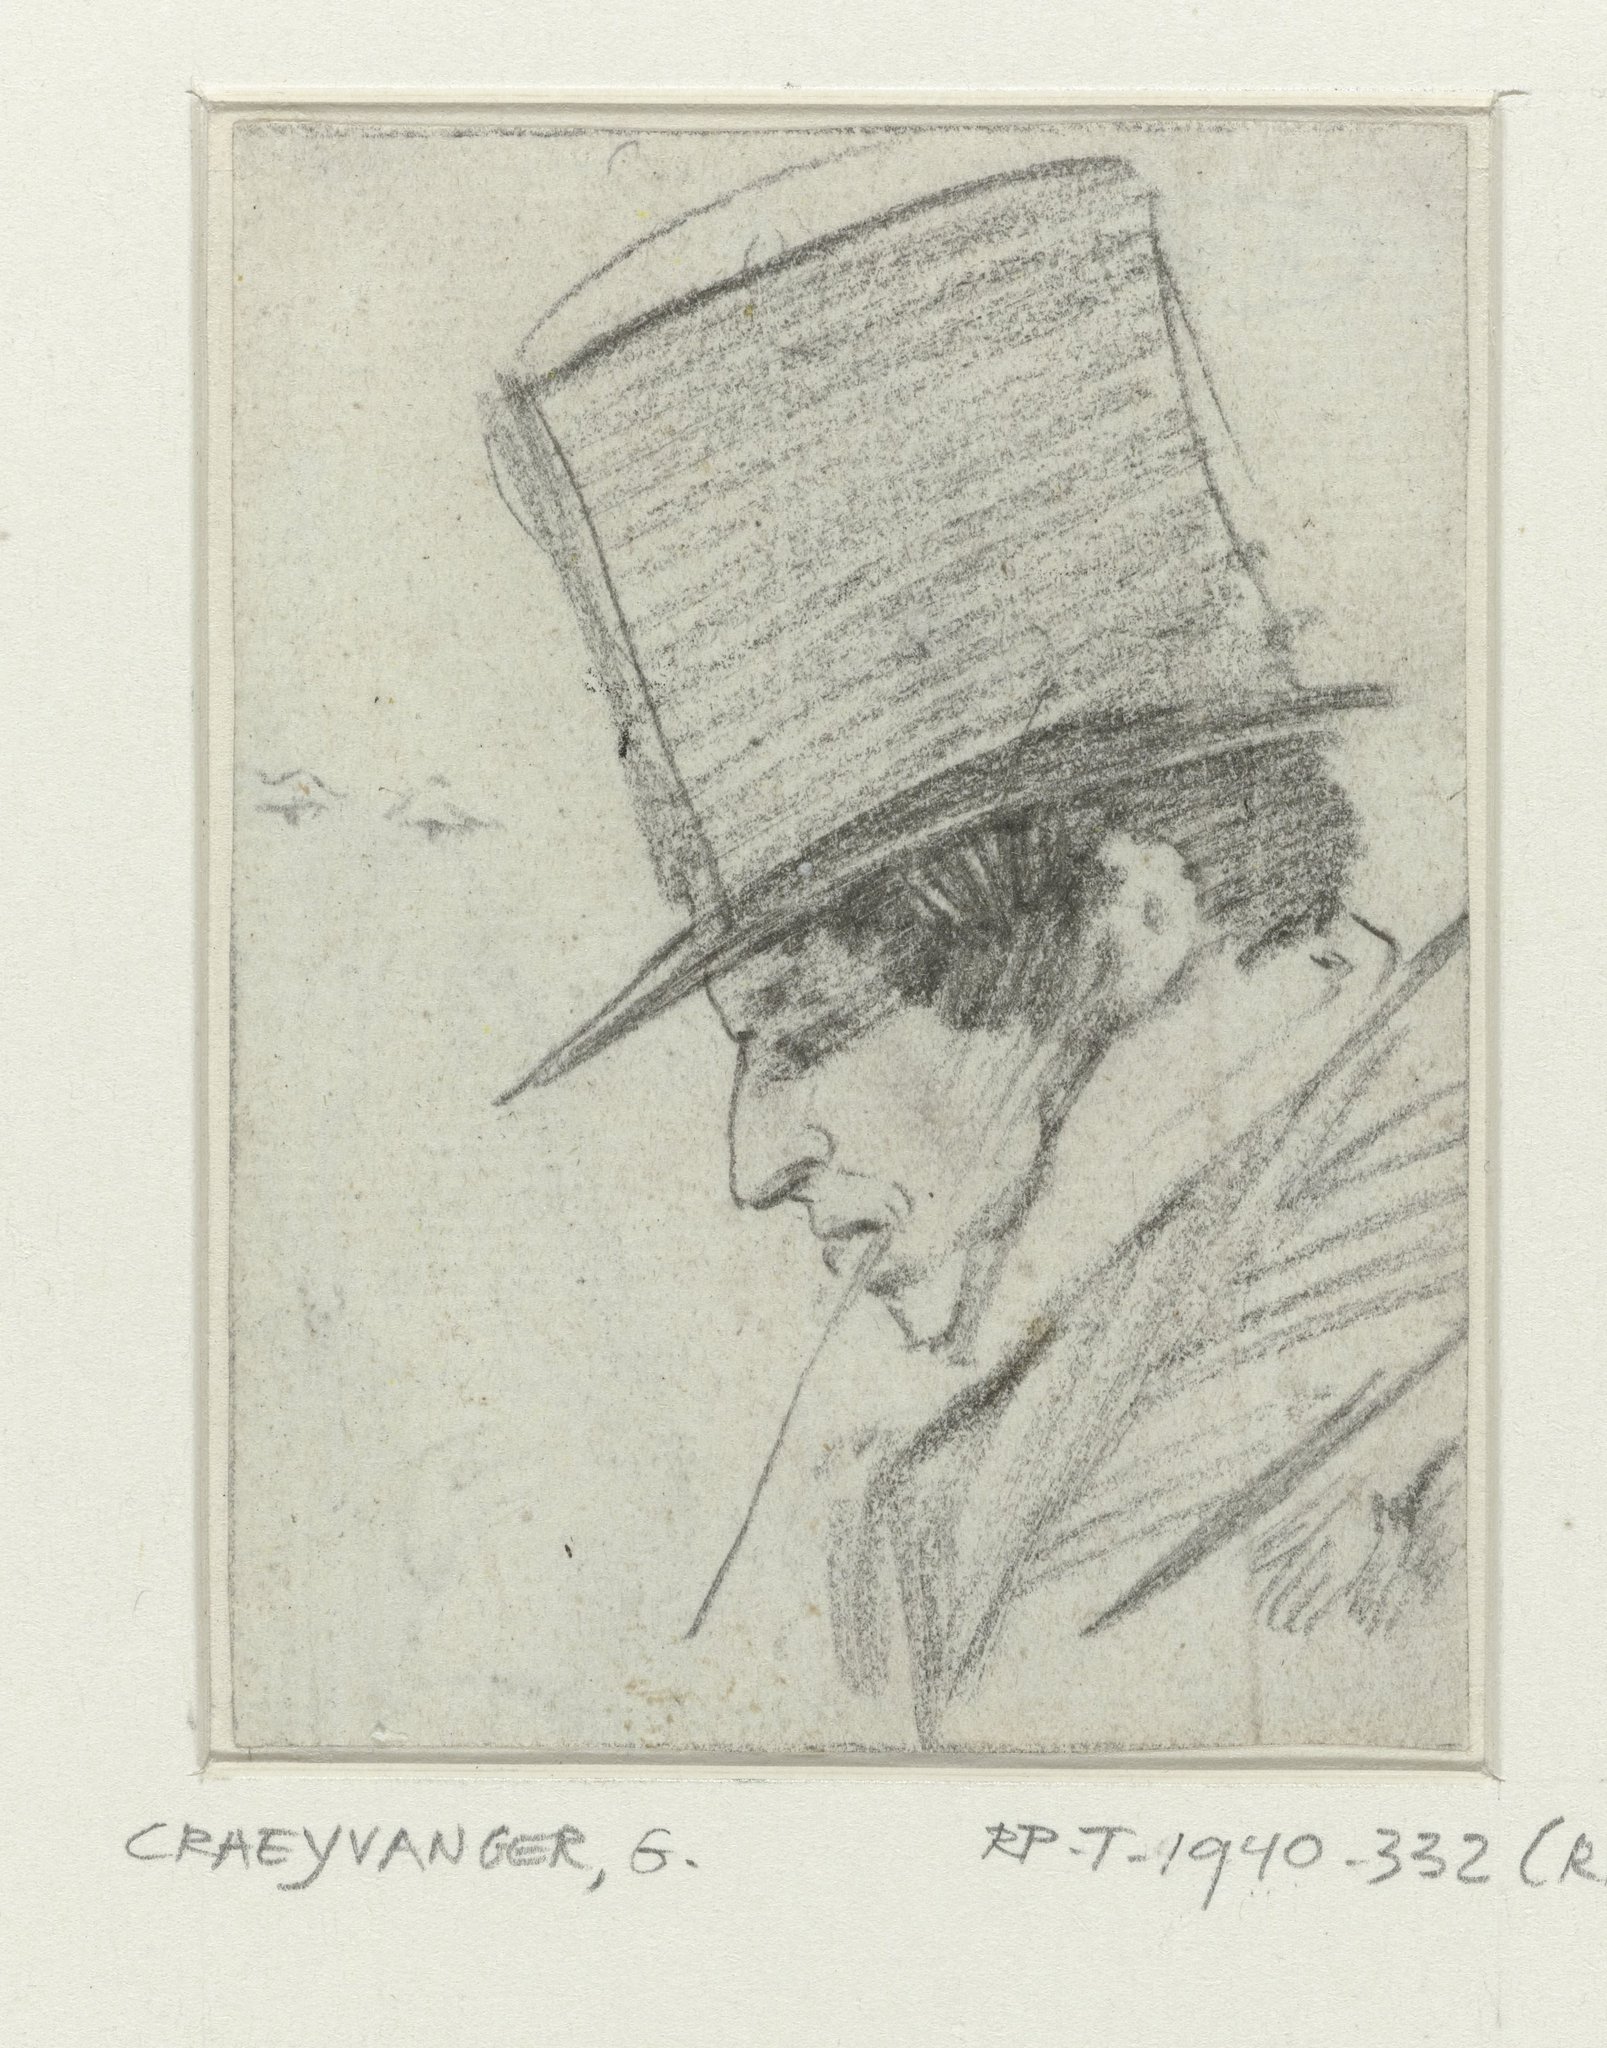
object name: drawing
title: Portret van de schilder Jan Hendrik Verheijen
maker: gijsbertus craeyvanger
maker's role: draughtsman, print maker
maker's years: 1810-1895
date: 1820-1895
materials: chalk, paper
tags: utrecht, draughtsman, jan hendrik verheijen, historical persons, portrait, self-portrait of painter, portrait, self-portrait of artist